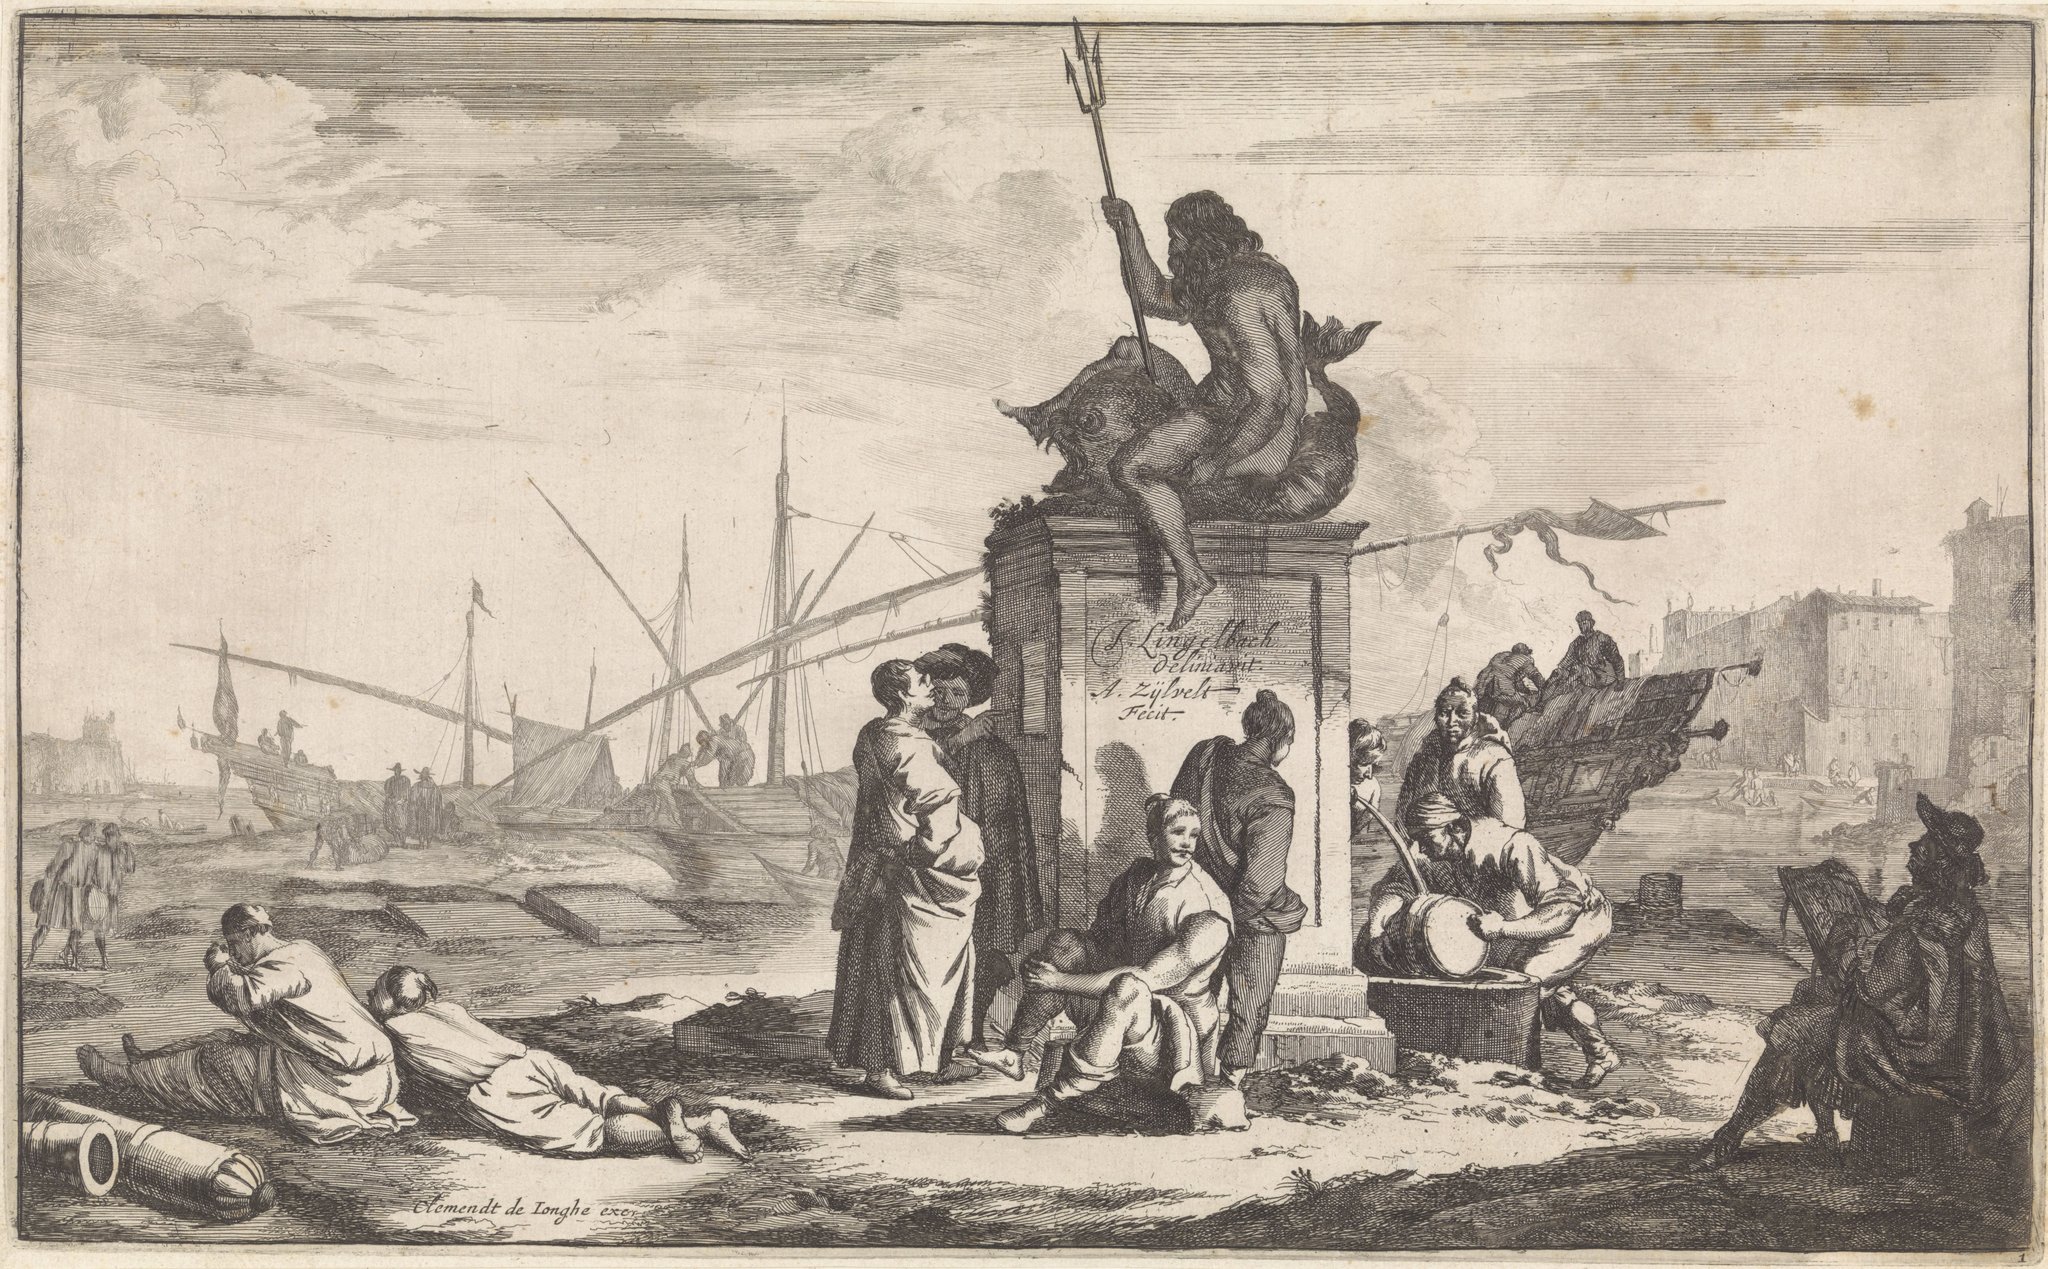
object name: print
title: Haven met het standbeeld van Neptunus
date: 1650-1695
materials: paper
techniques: etching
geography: amsterdam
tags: harbour, (story of) neptune (poseidon), monument, statue, draughtsman at work - cc - out of doors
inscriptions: collector's mark: Lugt 240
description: De haven van Genua met enkele mensen rond een standbeeld van Neptunus. Rechts een tekenende kunstenaar.